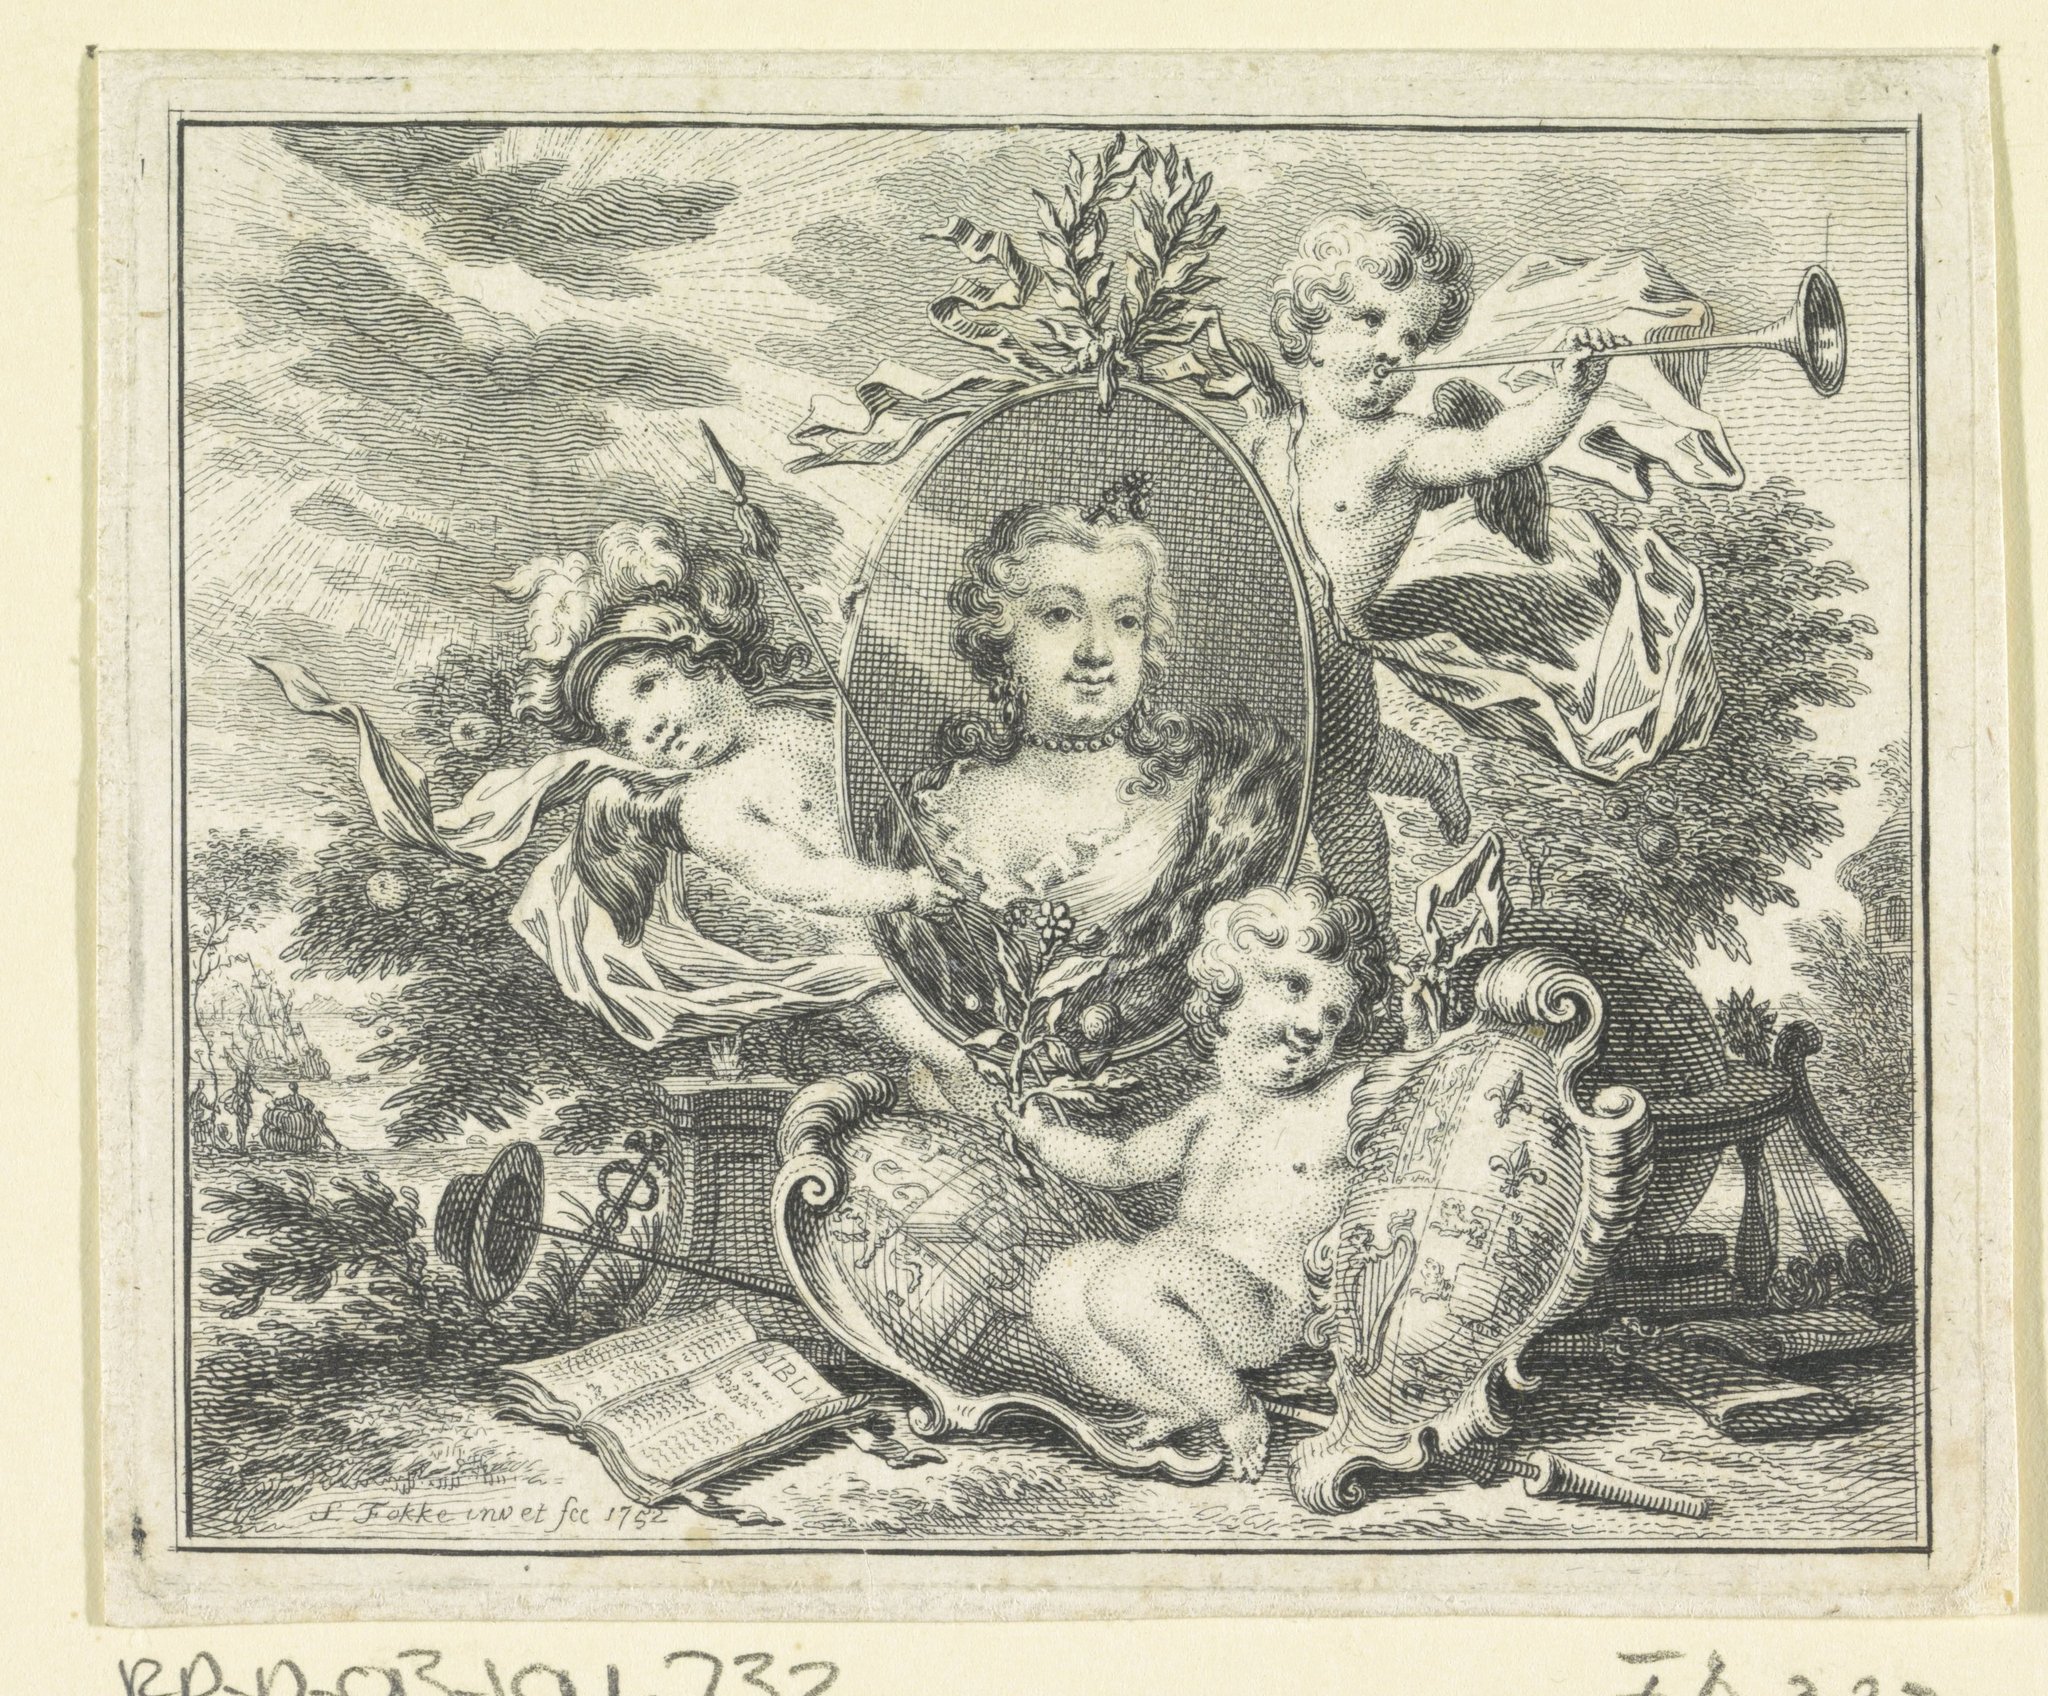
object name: print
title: Portret van Anna van Hannover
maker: simon fokke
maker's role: draughtsman, print maker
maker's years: 1712-1784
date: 1752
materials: paper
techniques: engraving, etching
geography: amsterdam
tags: anna van hannover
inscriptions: date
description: Portret van Anna in een ovaal. Daar omheen een aantal allegorische objecten en figuren.